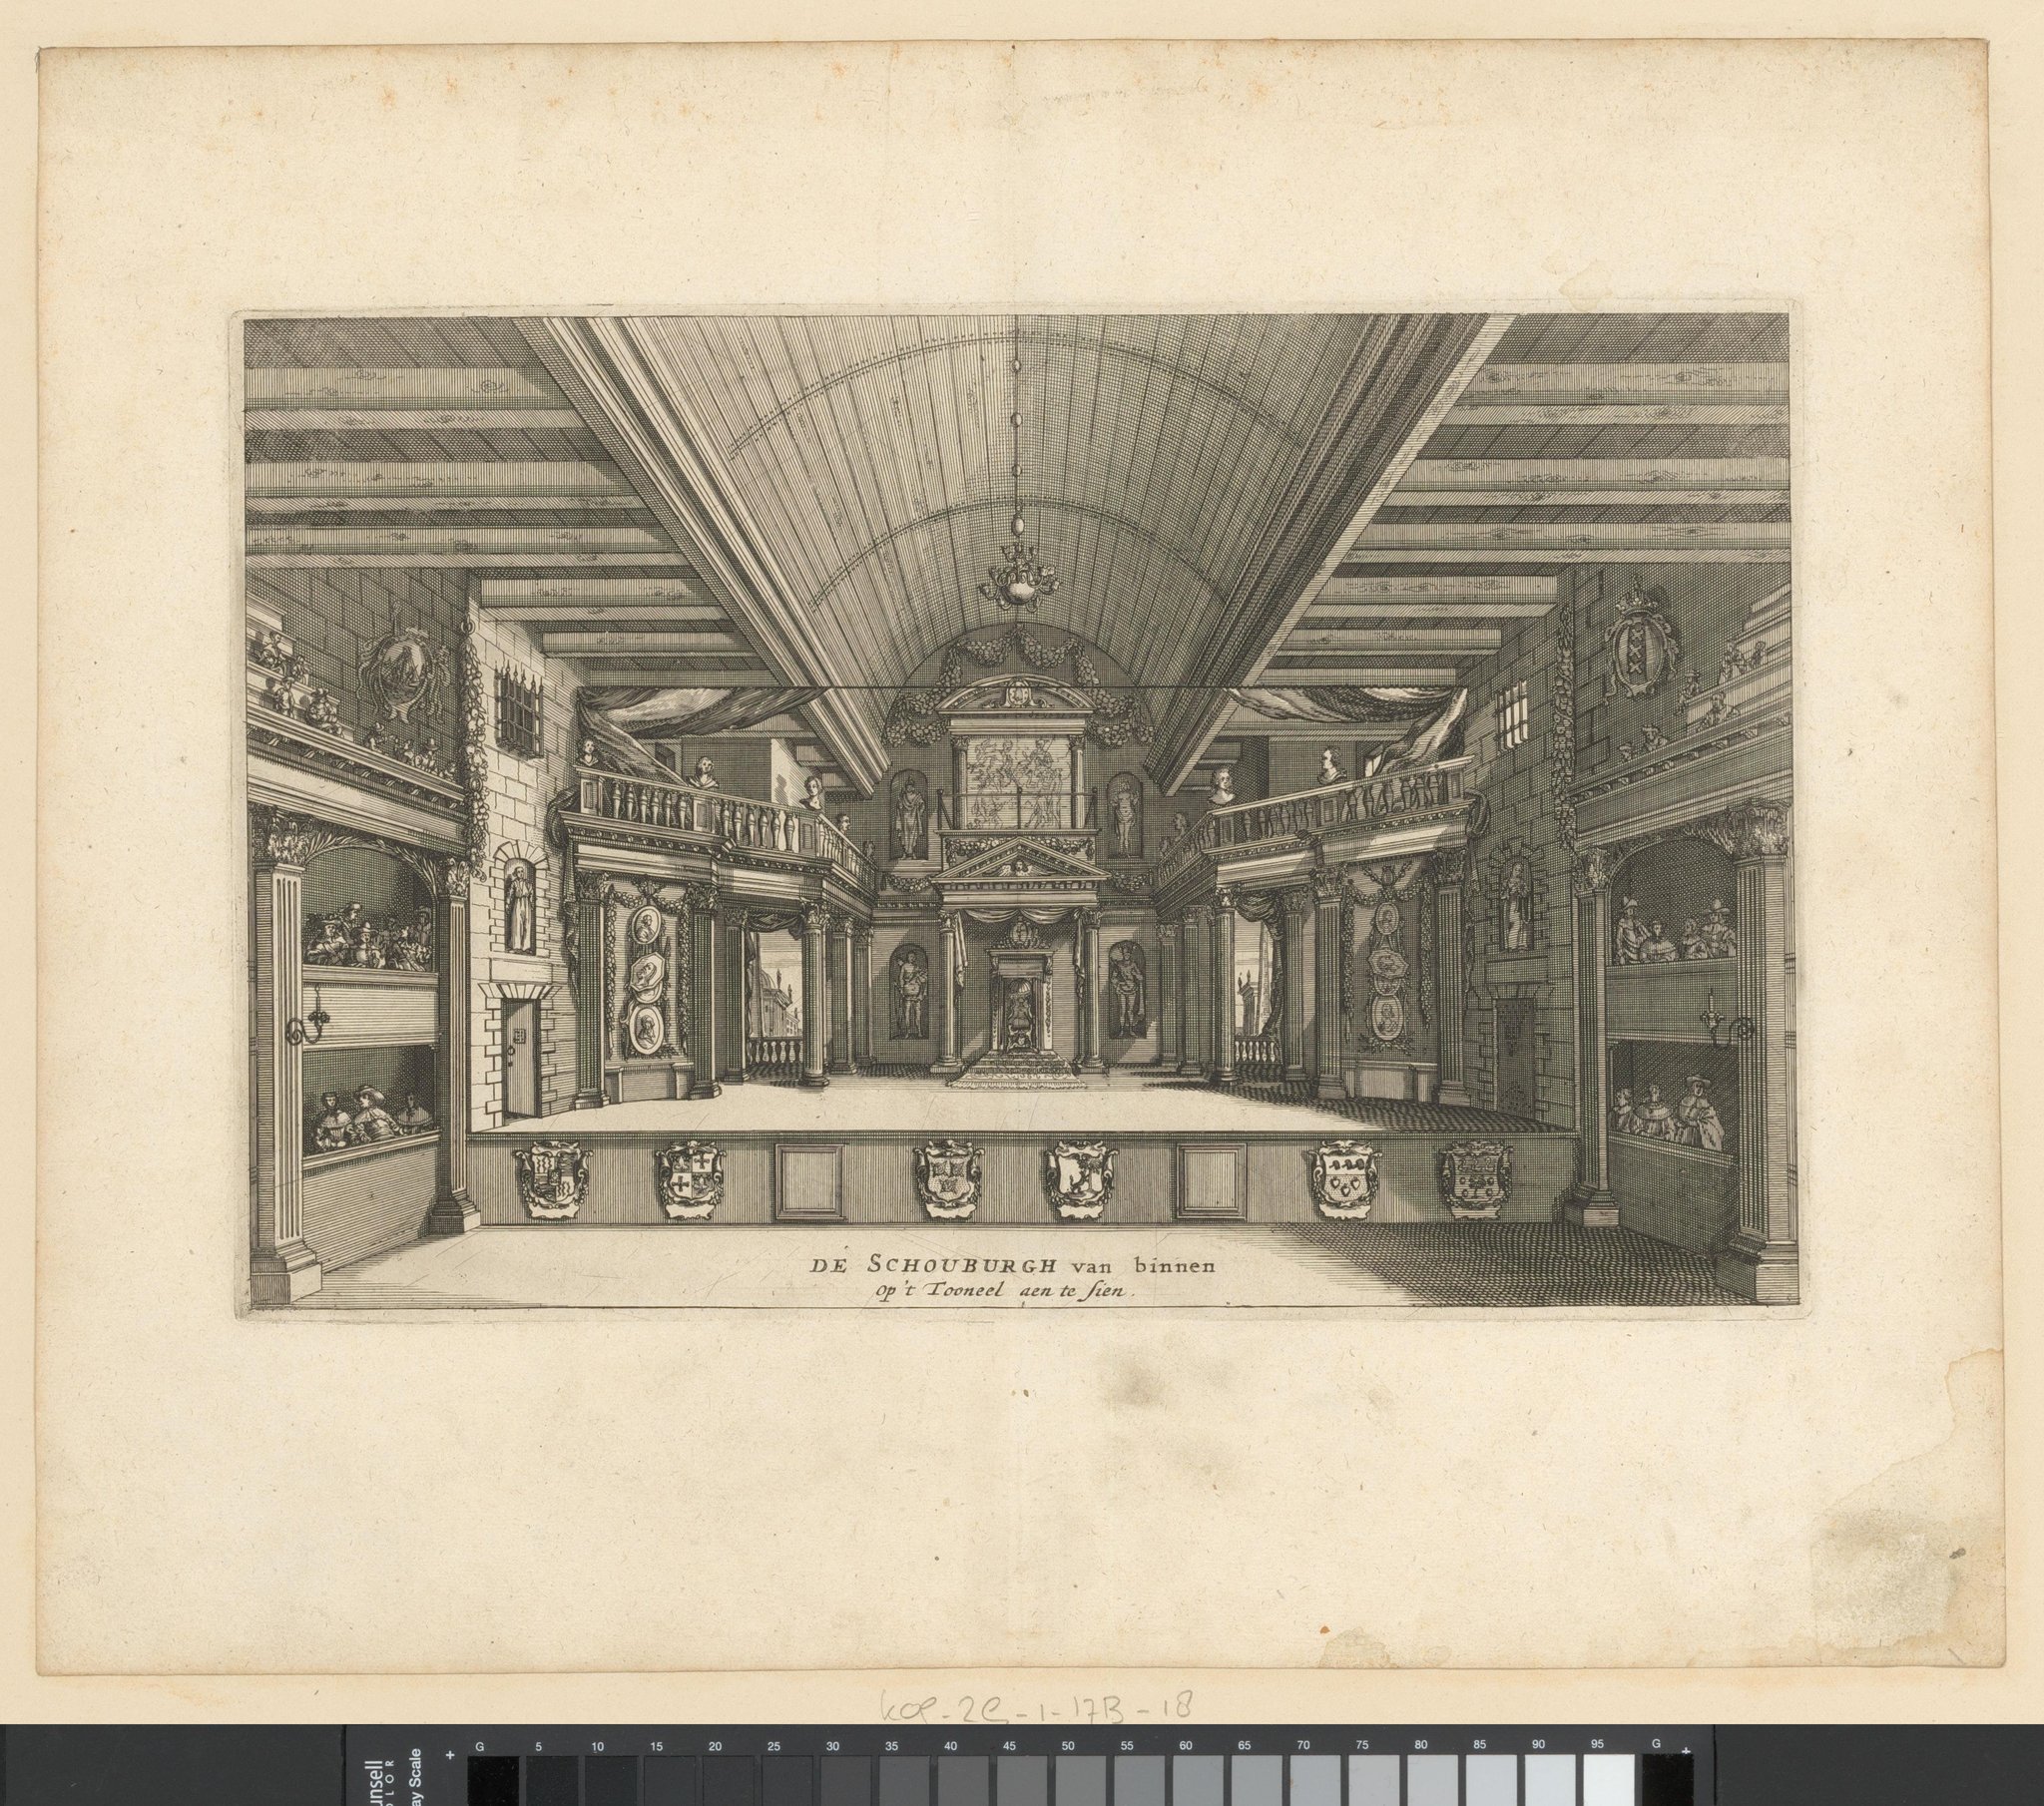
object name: print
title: Toneel van de Amsterdamse Schouwburg aan de Keizersgracht te Amsterdam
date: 1663-1664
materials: paper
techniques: engraving, etching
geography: amsterdam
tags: coat of arms (as symbol of the state, etc.) (+ city; municipal), theatre (building), the stage and its equipment, armorial bearing, heraldry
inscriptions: stamp, collector's mark: Lugt 1641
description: Gezicht op het toneel van de Amsterdamse Schouwburg aan de Keizersgracht. Op de voorgrond de wapens van bestuurders van de schouwburg, met rechts van het midden het wapen van Jan Vos. In werkelijkheid hingen deze schilden er niet. Deze stadsschouwburg was ontworpen door Jacob van Campen en was op de plaats van de Nederduitse Academie van Samuel Coster gebouwd (ter hoogte van de huidige Keizersgracht 384). Op 26 december 1637 was de opening. In 1665 werd het gebouw ingrijpend verbouwd en in 1772 brandde het af. Onderwerpsrubrieken binnen de Atlas Zeden en Gewoonten: Schoone kunsten, Tooneel, Schouwburg op de Keizersgracht (1637 – 1772).